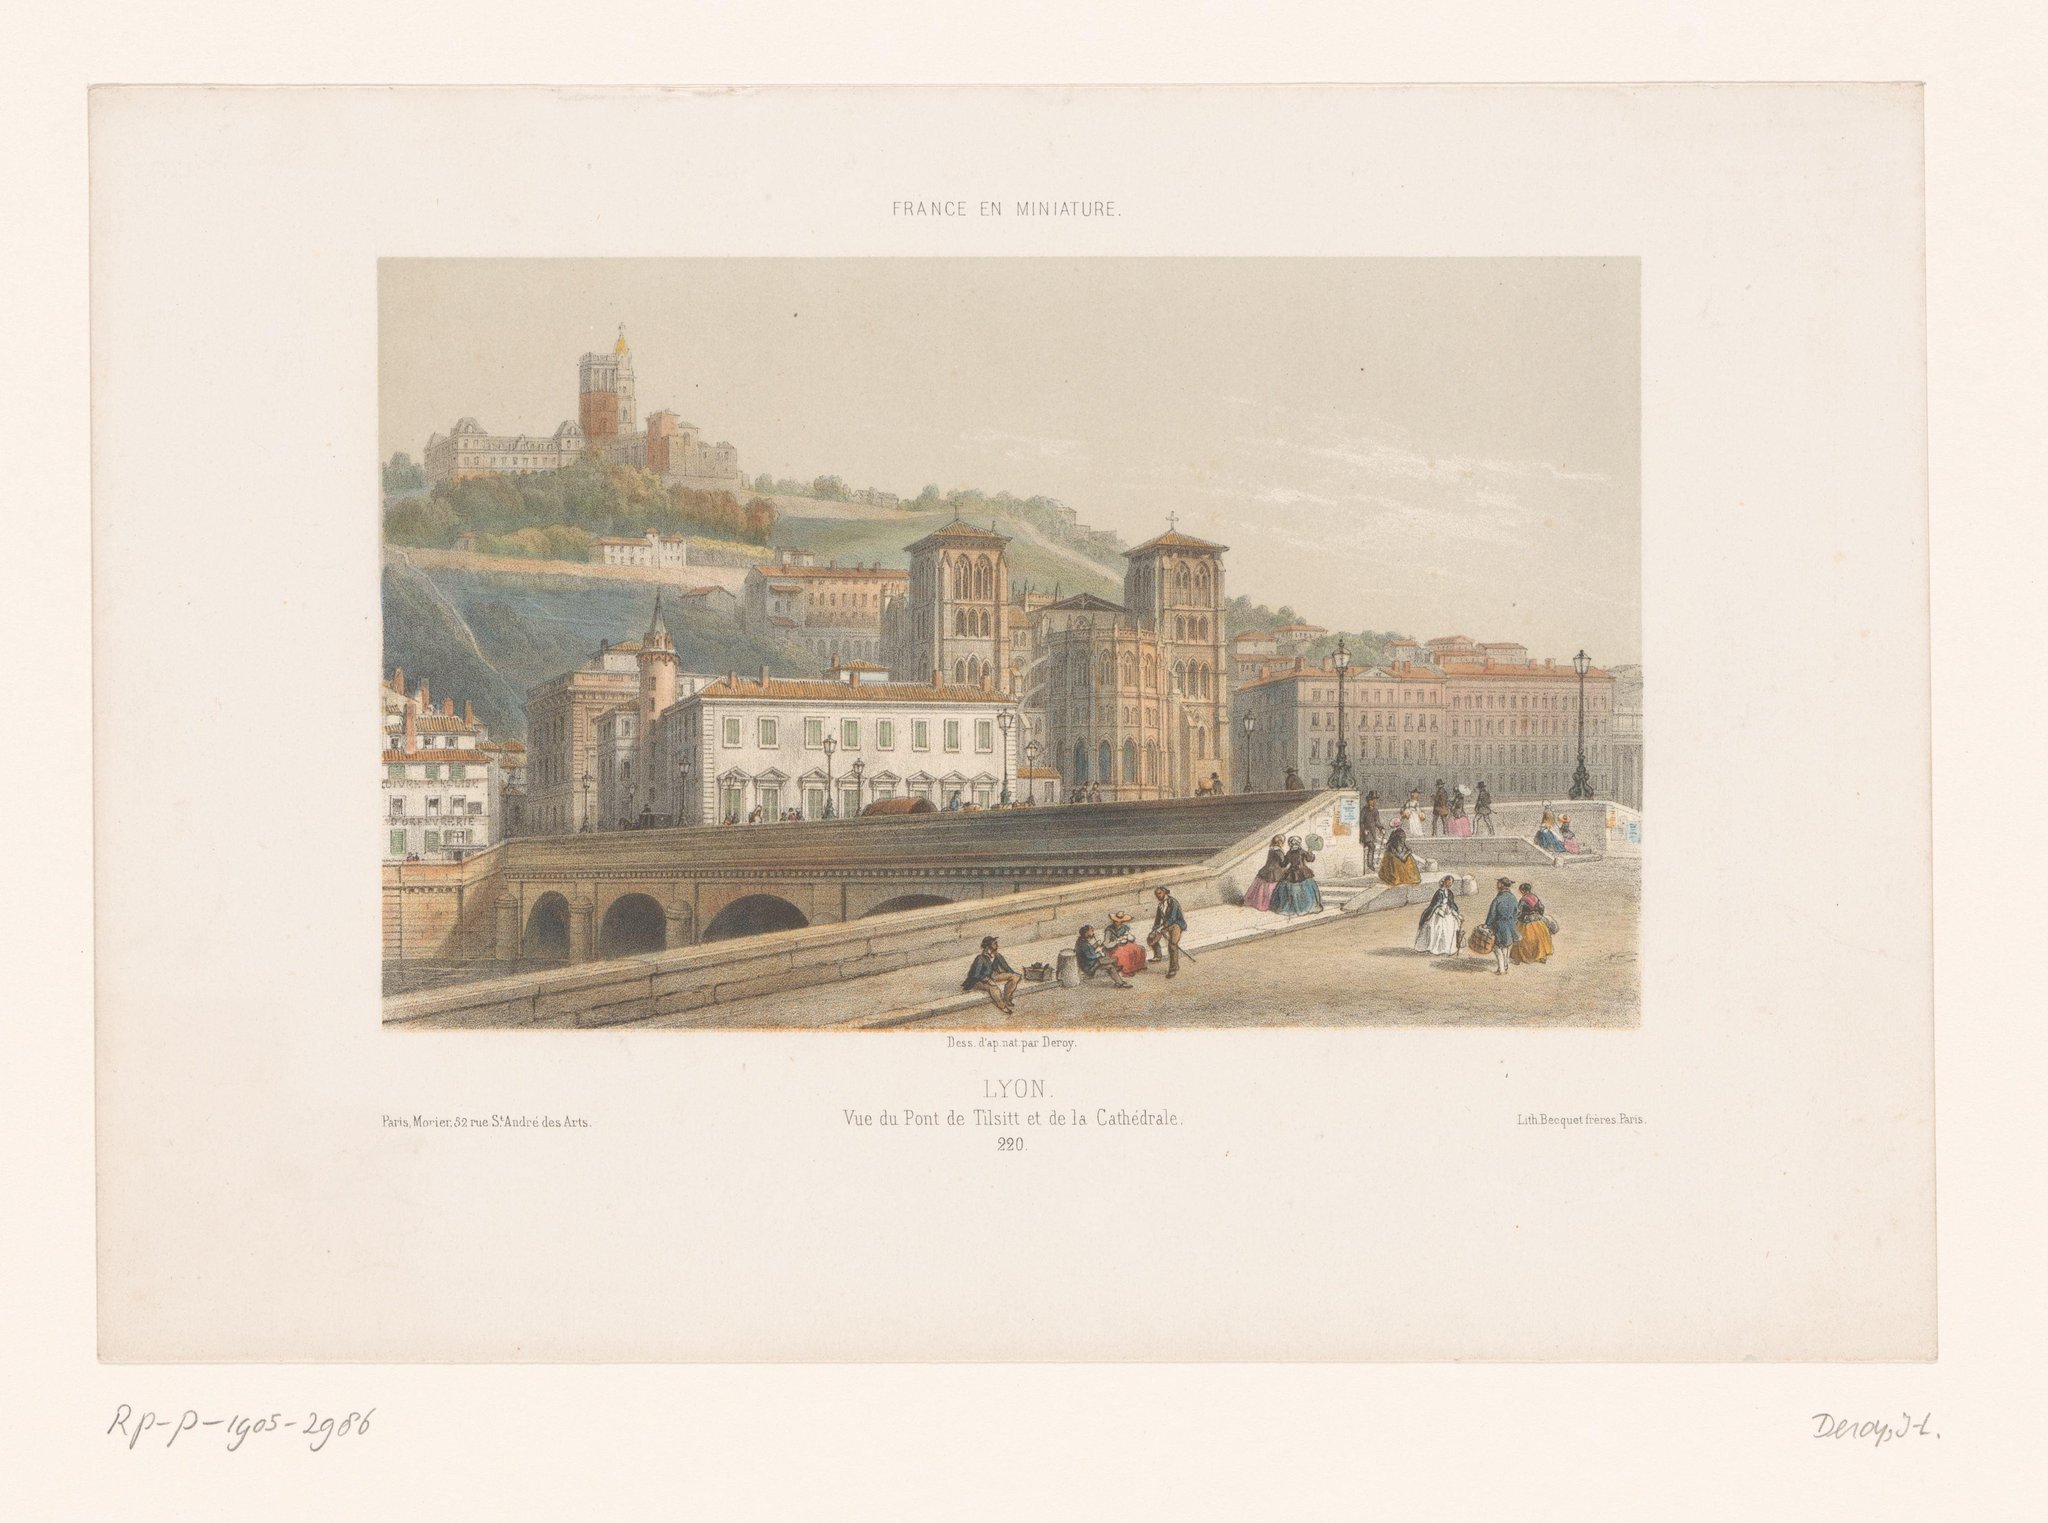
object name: print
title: Kleine gezichten in Frankrijk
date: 1861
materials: paper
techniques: hand coloring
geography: lyon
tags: church (exterior), bridge in city across river, canal, etc., prospect of city, town panorama, silhouette of city (+ city(-scape) with figures, staffage)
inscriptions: collector's mark: Lugt 2228a